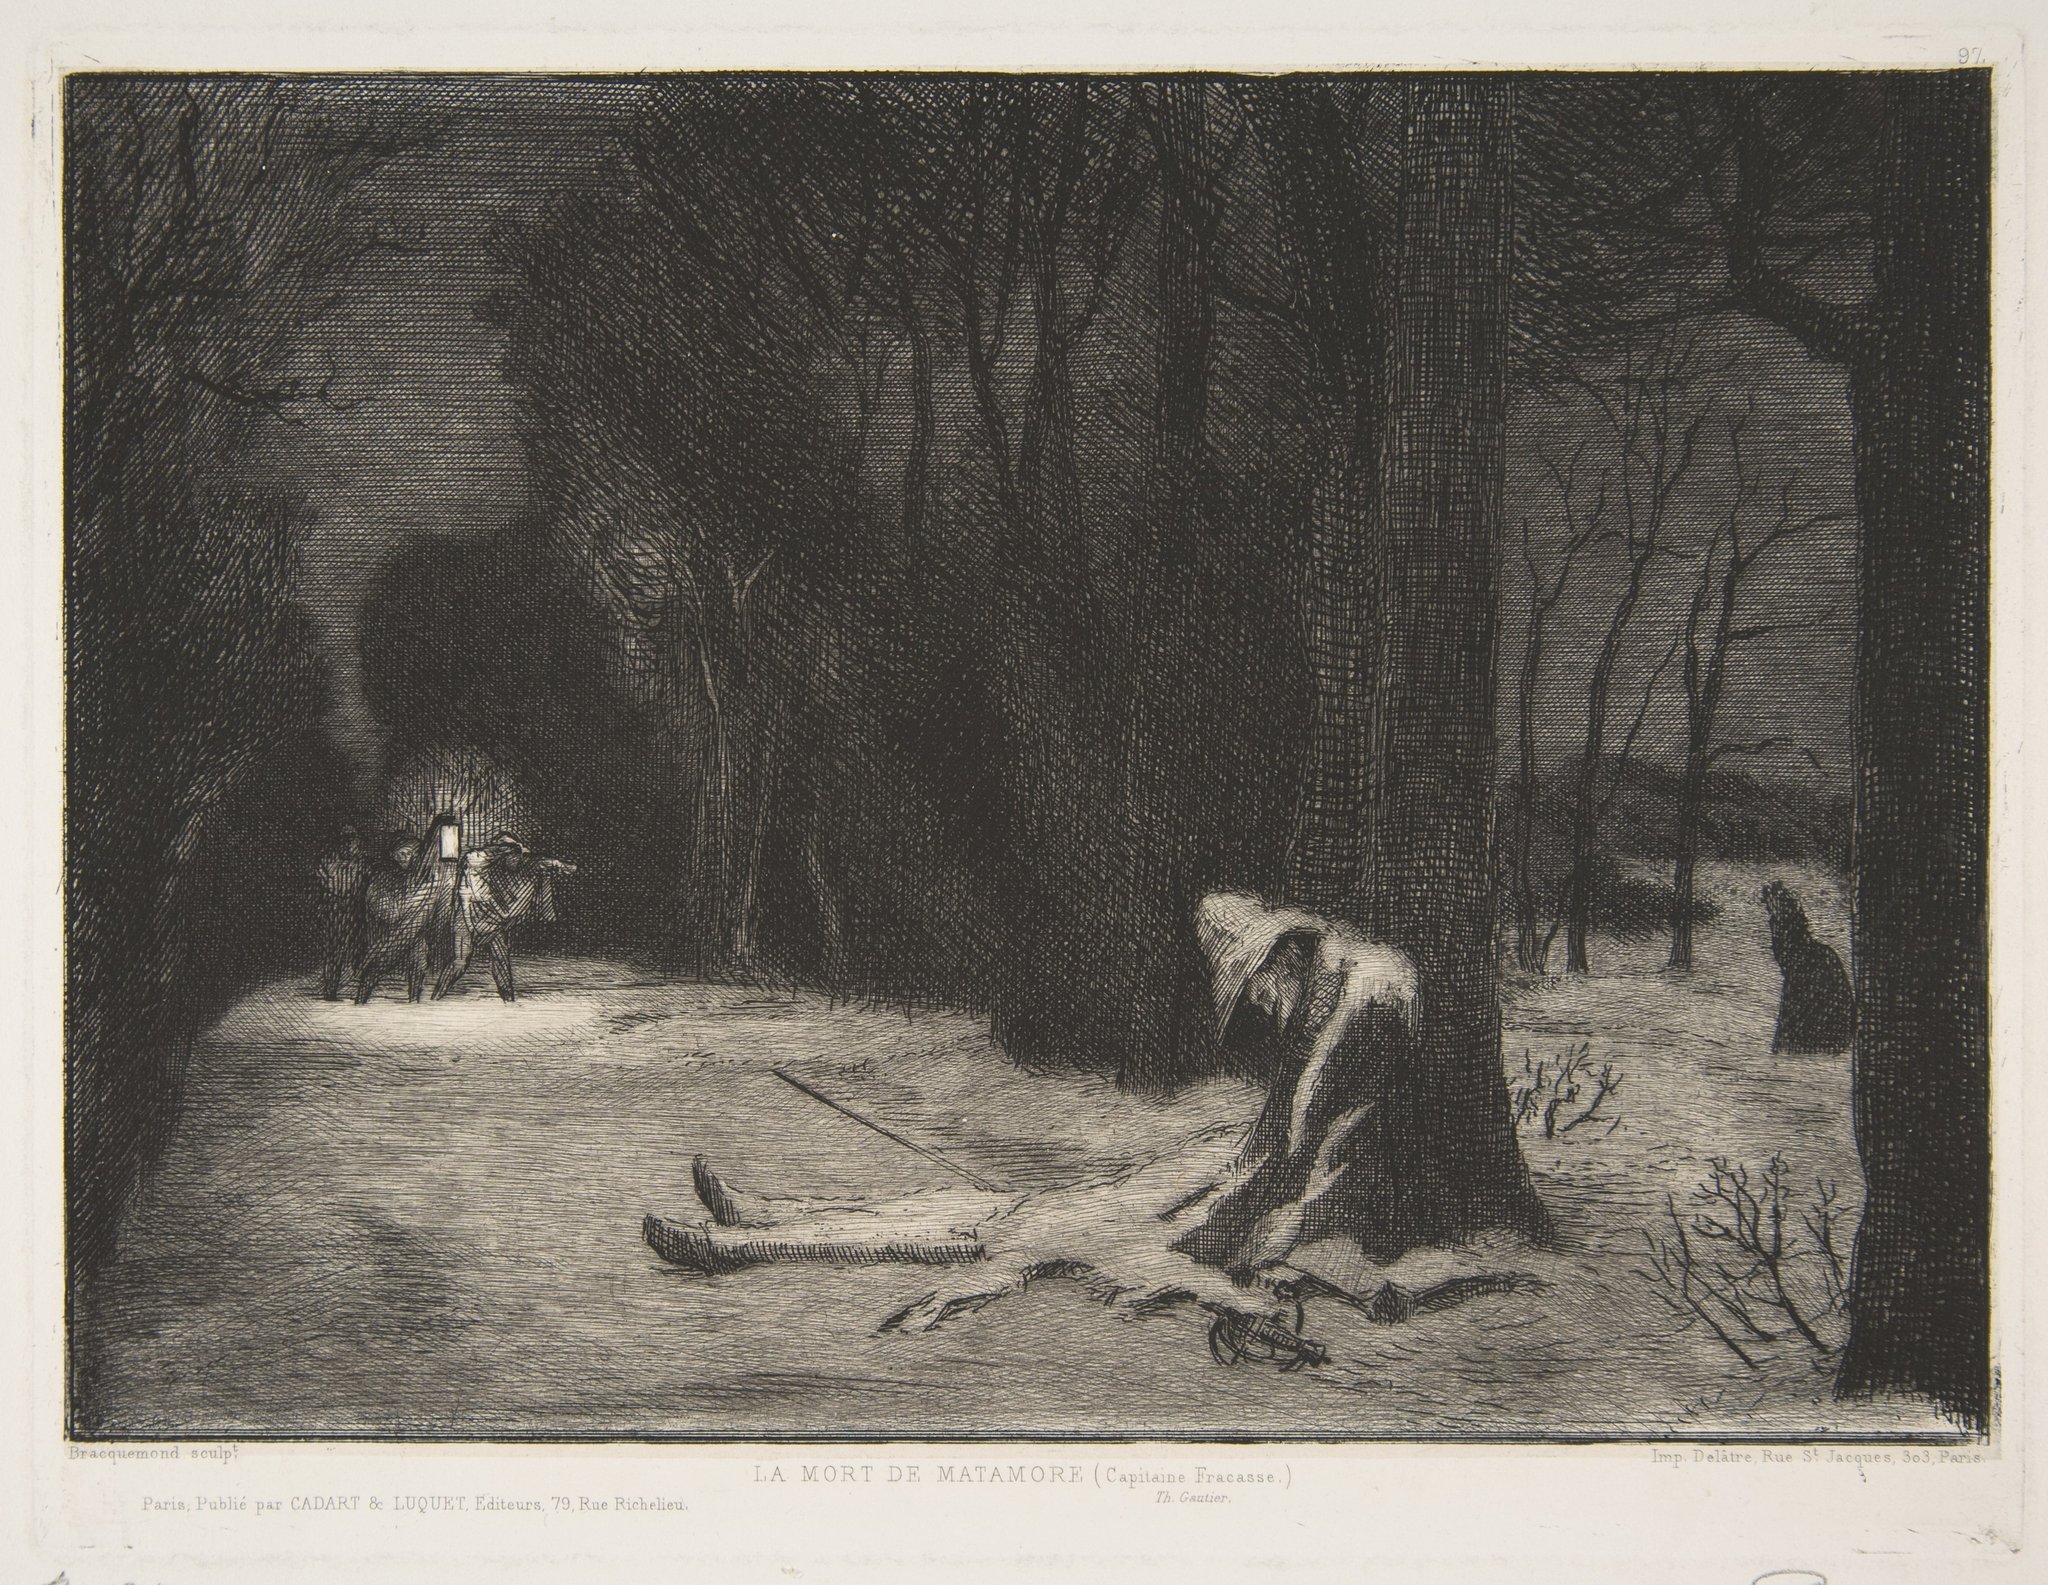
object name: print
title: La Mort de Matamore (Capitaine Fracasse)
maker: félix bracquemond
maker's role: artist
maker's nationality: french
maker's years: 1833-1914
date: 1864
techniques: etching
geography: france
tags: men,trees,death